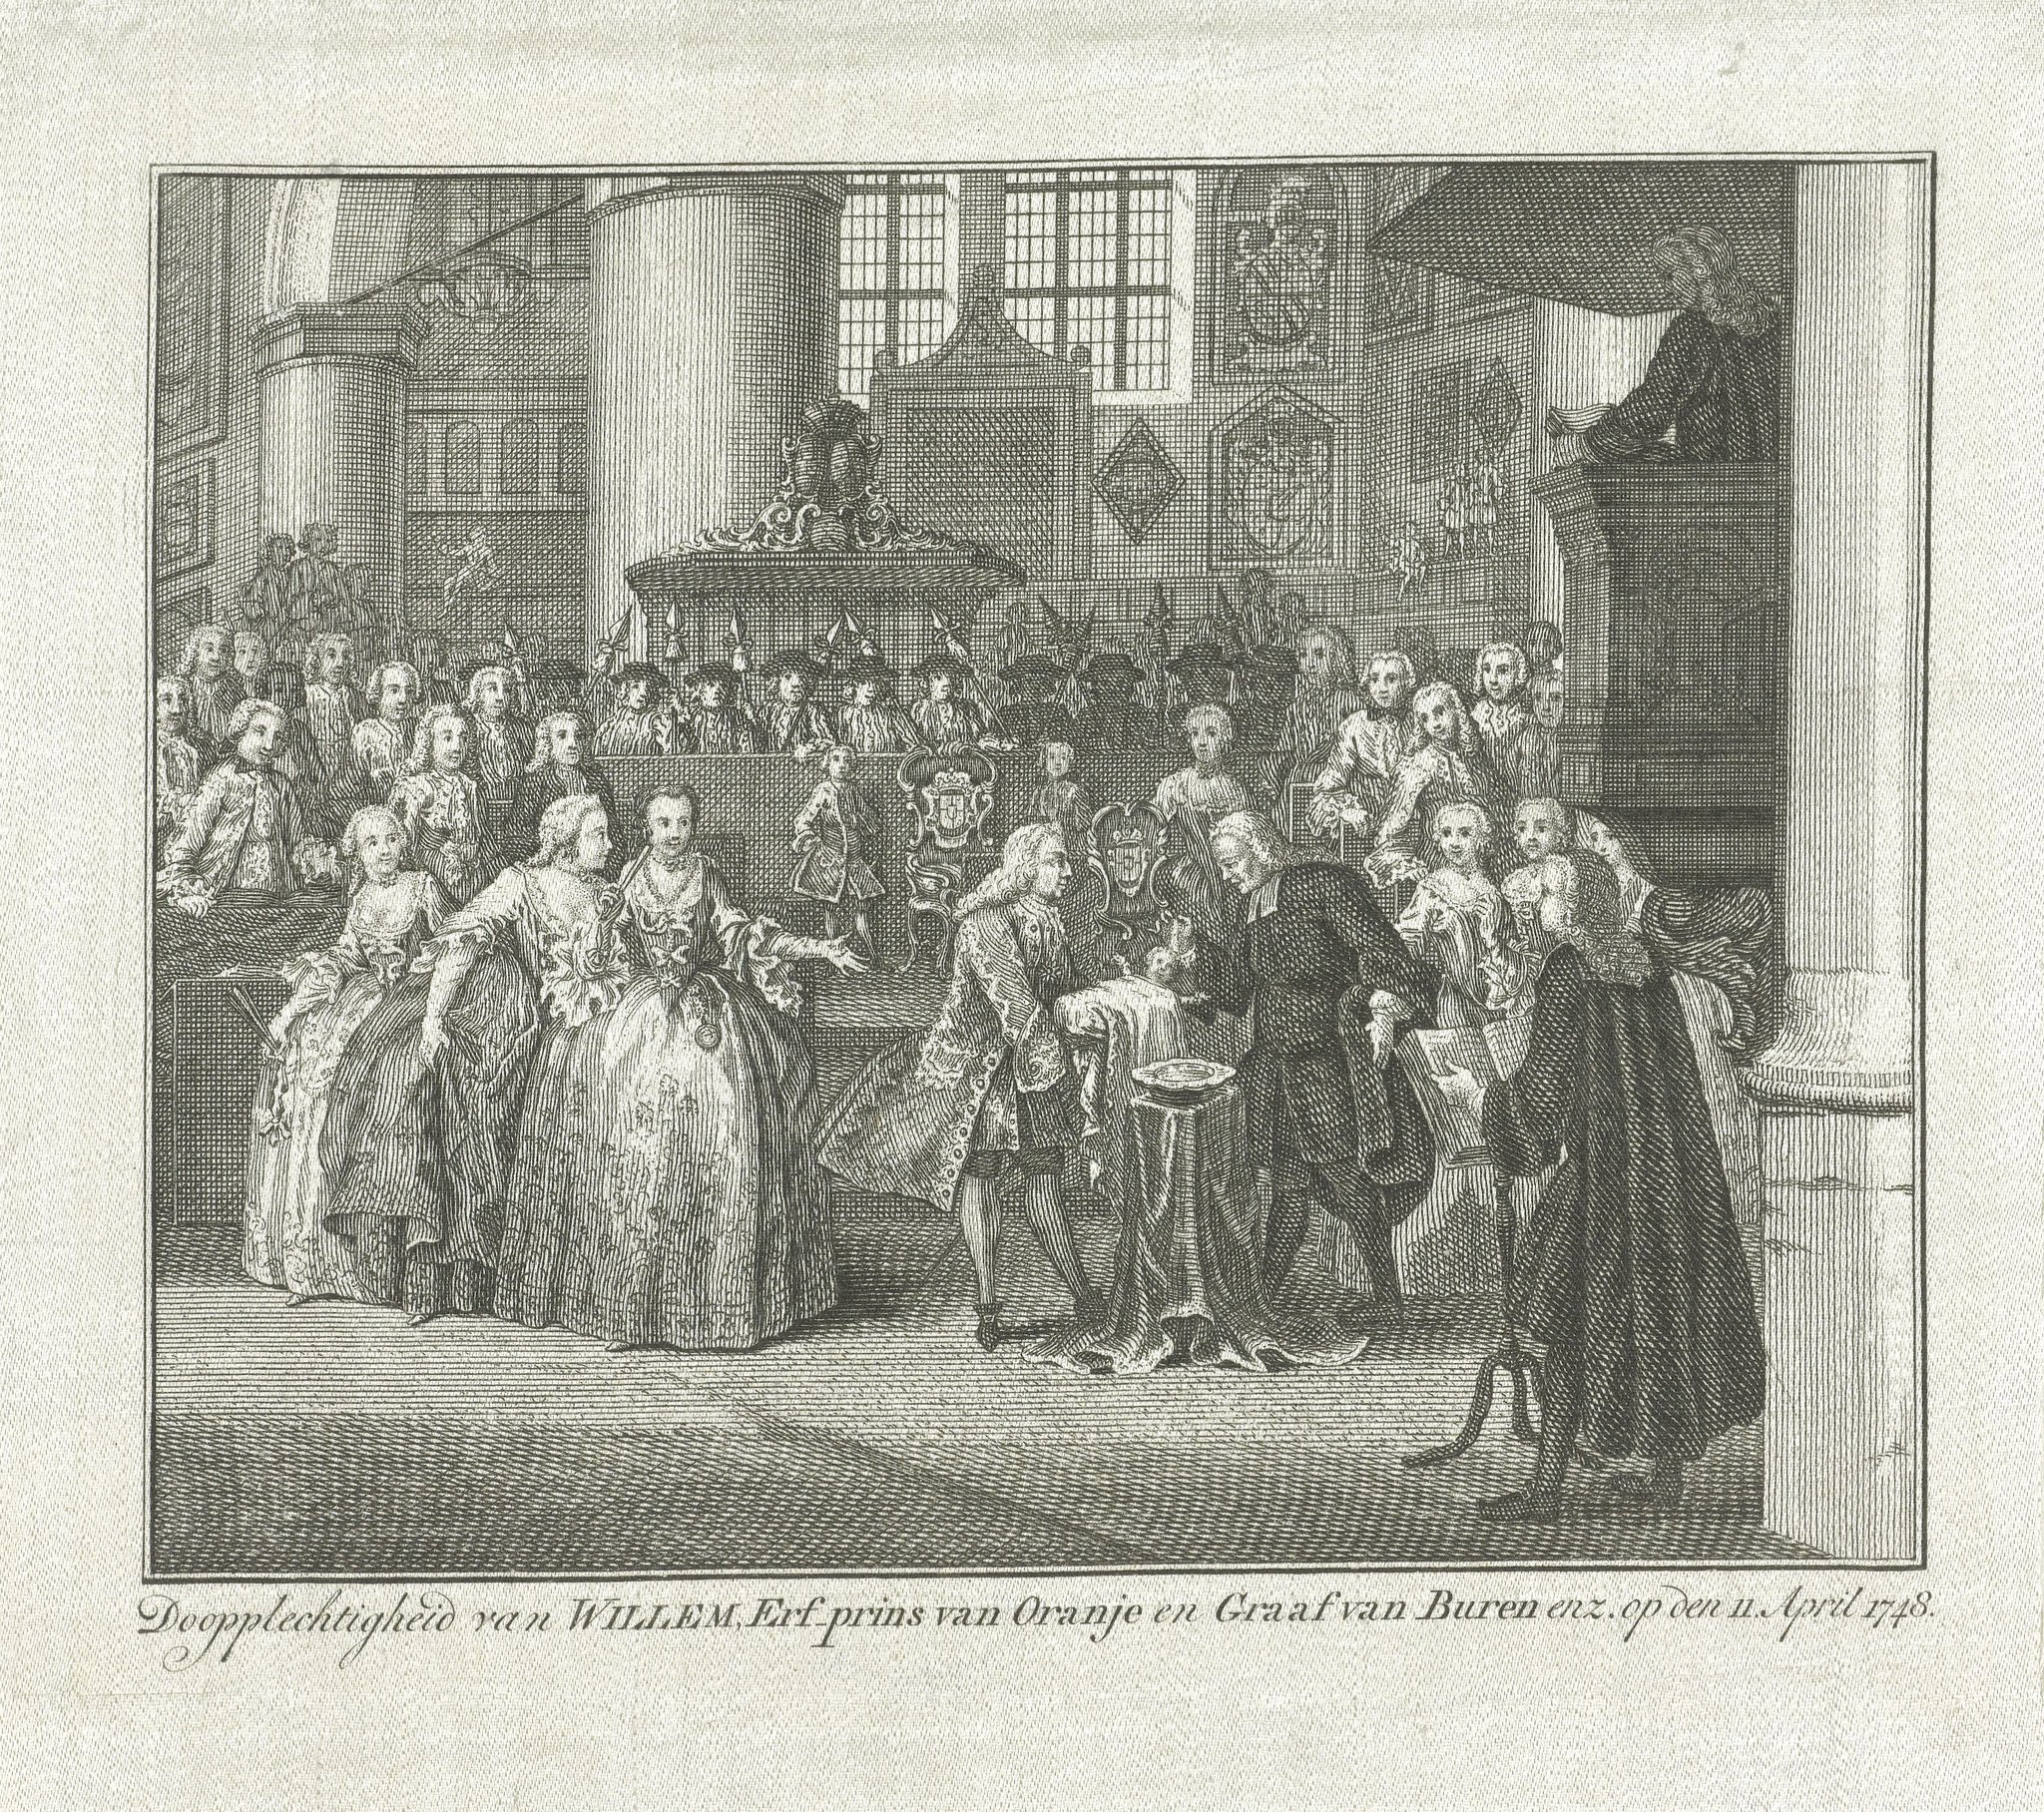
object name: print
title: Doopplechtigheid van Willem, Erf-prins van Oranje en Graaf van Buren enz. op den 11 April 1748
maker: gerard sibelius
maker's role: print maker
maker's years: 1734-1785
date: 1750-1752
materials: textile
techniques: engraving, etching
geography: northern netherlands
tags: william v (prince of orange), willem iv (prins van oranje-nassau), anna van hannover, baptism ~ protestant service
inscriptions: collector's mark: Lugt 2228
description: Gebruikt als illustratie in: J.L. Schuer, Nederlands merkwaardigste gebeurtenissen sedert byna twee eeuwen. Amsterdam: Steven van Esveldt, 1752. Kopie naar de prent van Simon Fokke uit 1748, FMH 3929a.